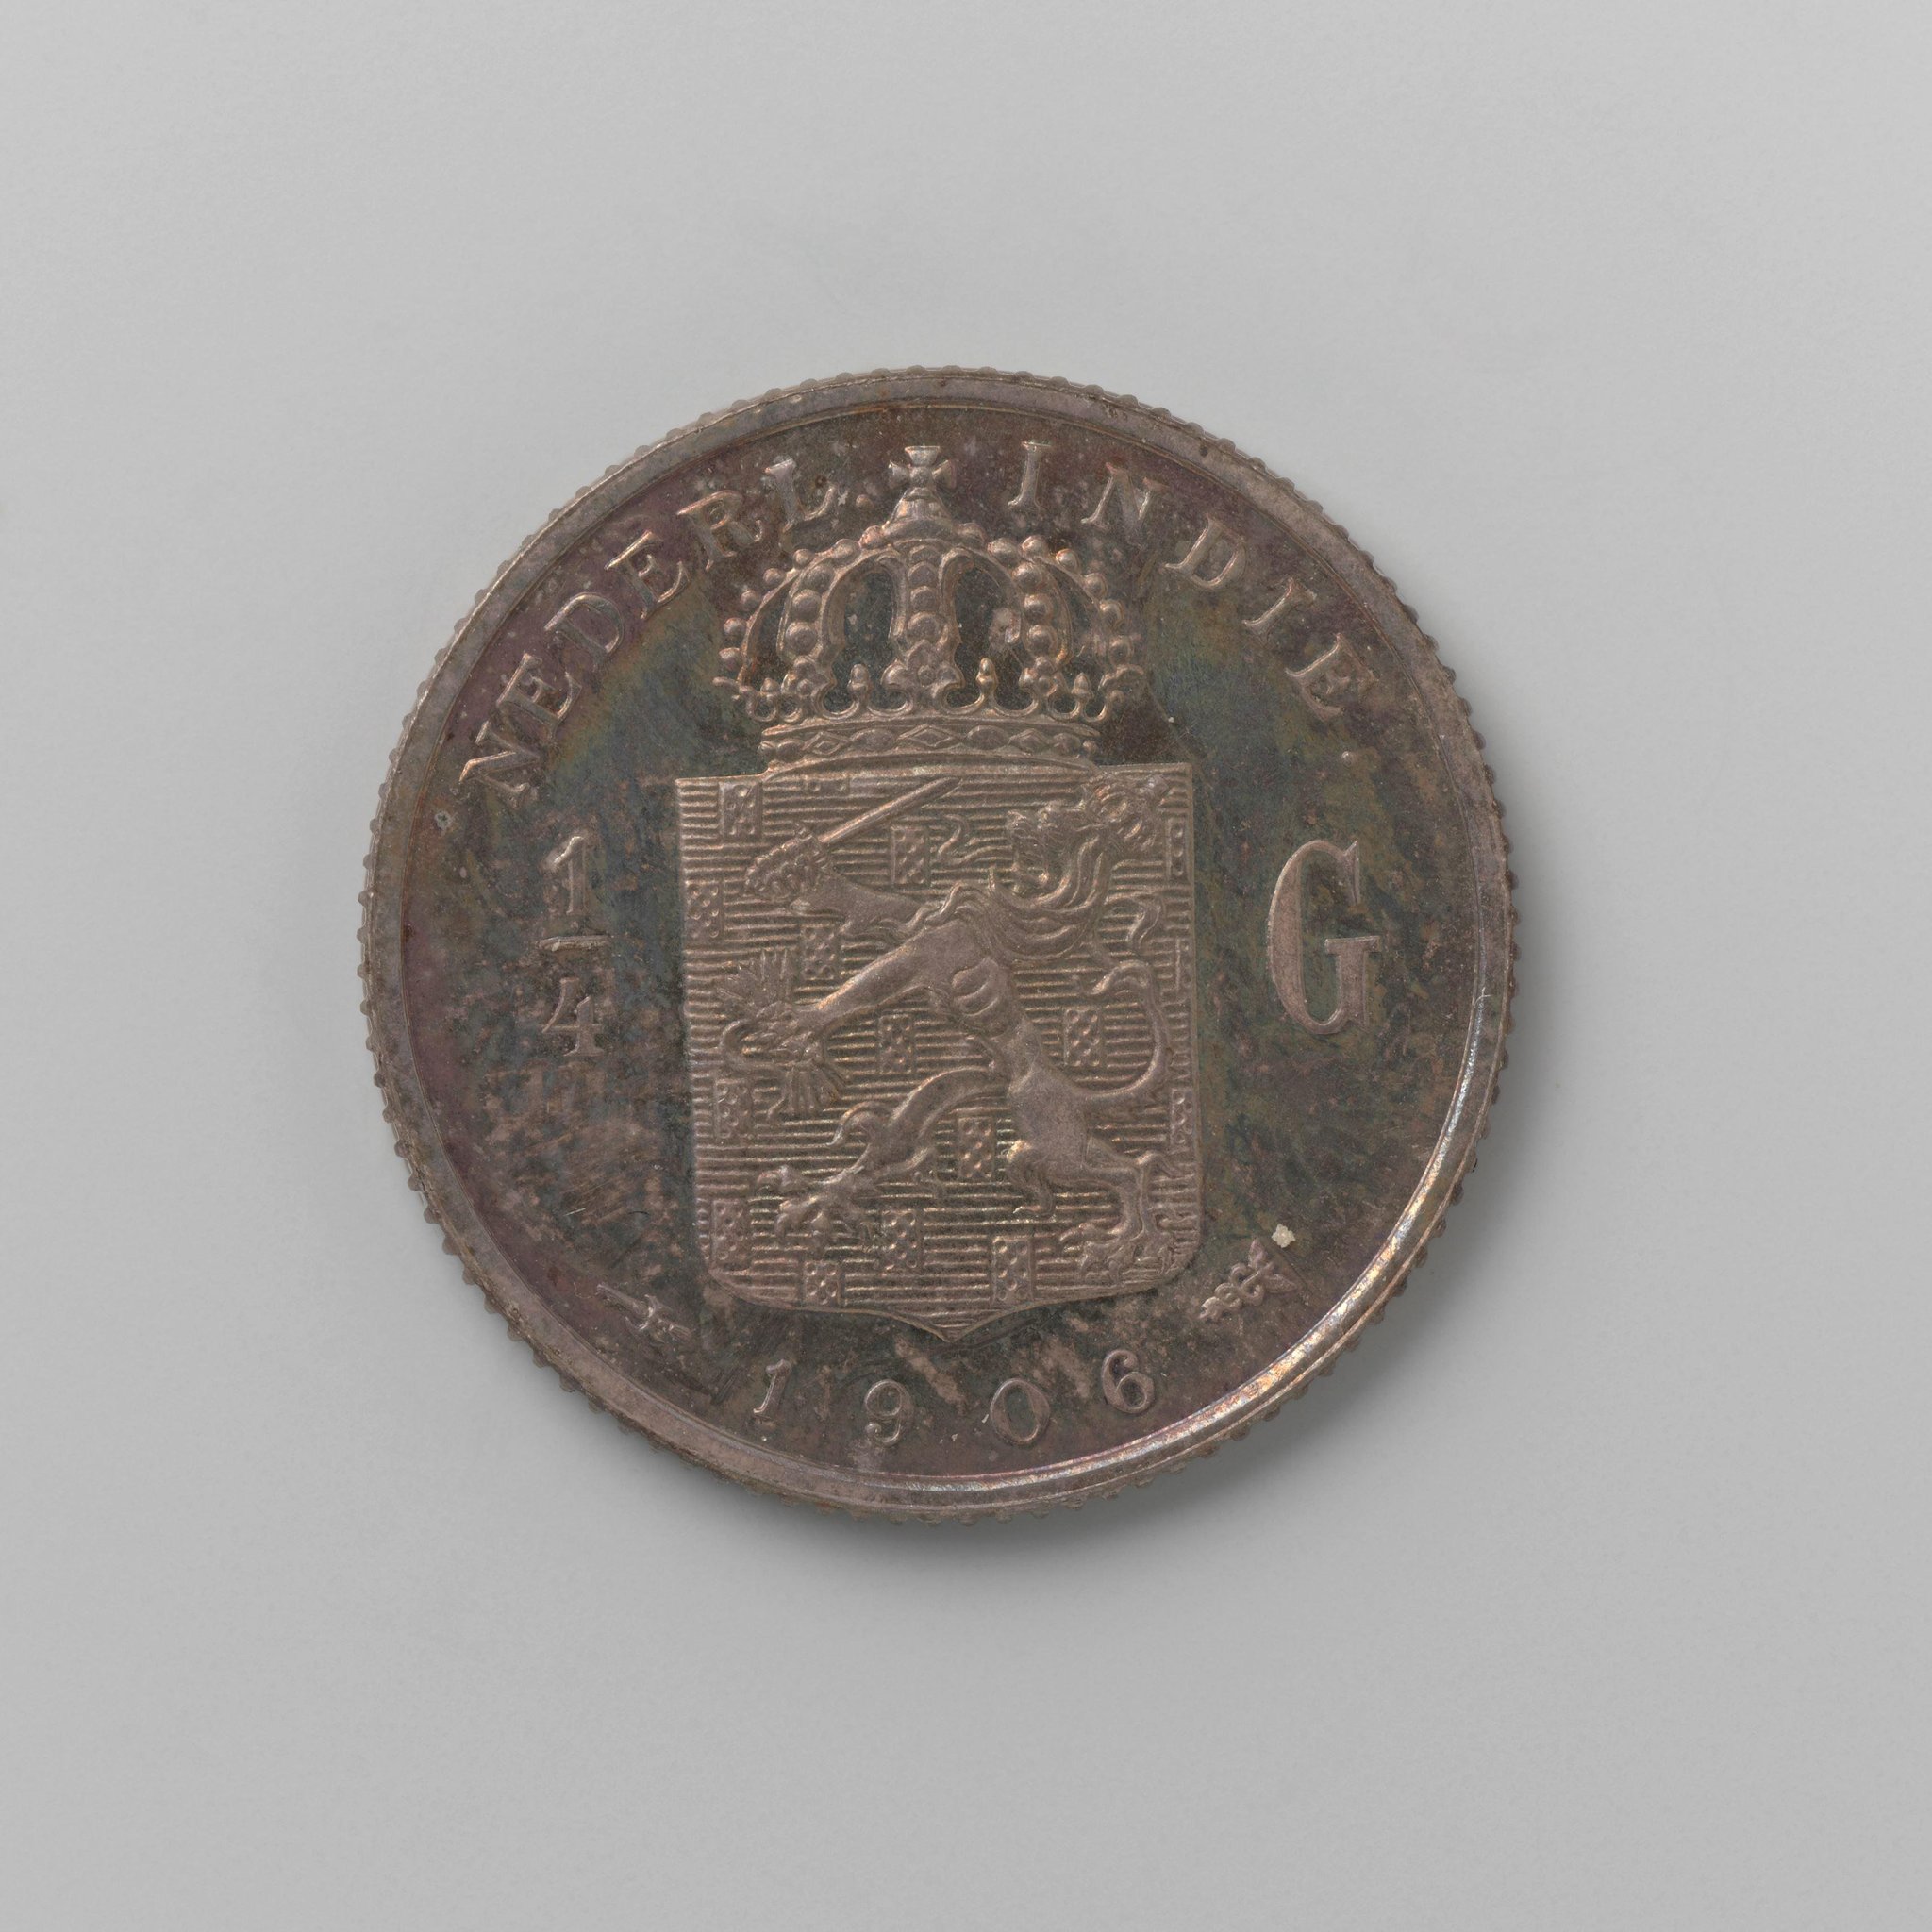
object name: coin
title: Nederlands Indië,1/4 gulden,1906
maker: wilhelmina of the netherlands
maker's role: print maker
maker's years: 1880-1962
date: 1906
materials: silver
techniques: striking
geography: utrecht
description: Zilveren munt. Voorzijde: tussen waarde-aanduiding 1/4 G gekroond rijkswapenschild. Boven kroon landsaanduiding en onder wapenschild jaartal. Keerzijde: drieregelig Maleis opschrift in Arabische tekens, waaromheen tussen zeven uitschietende stralen omschrift in het Javaans. Kartelrand.